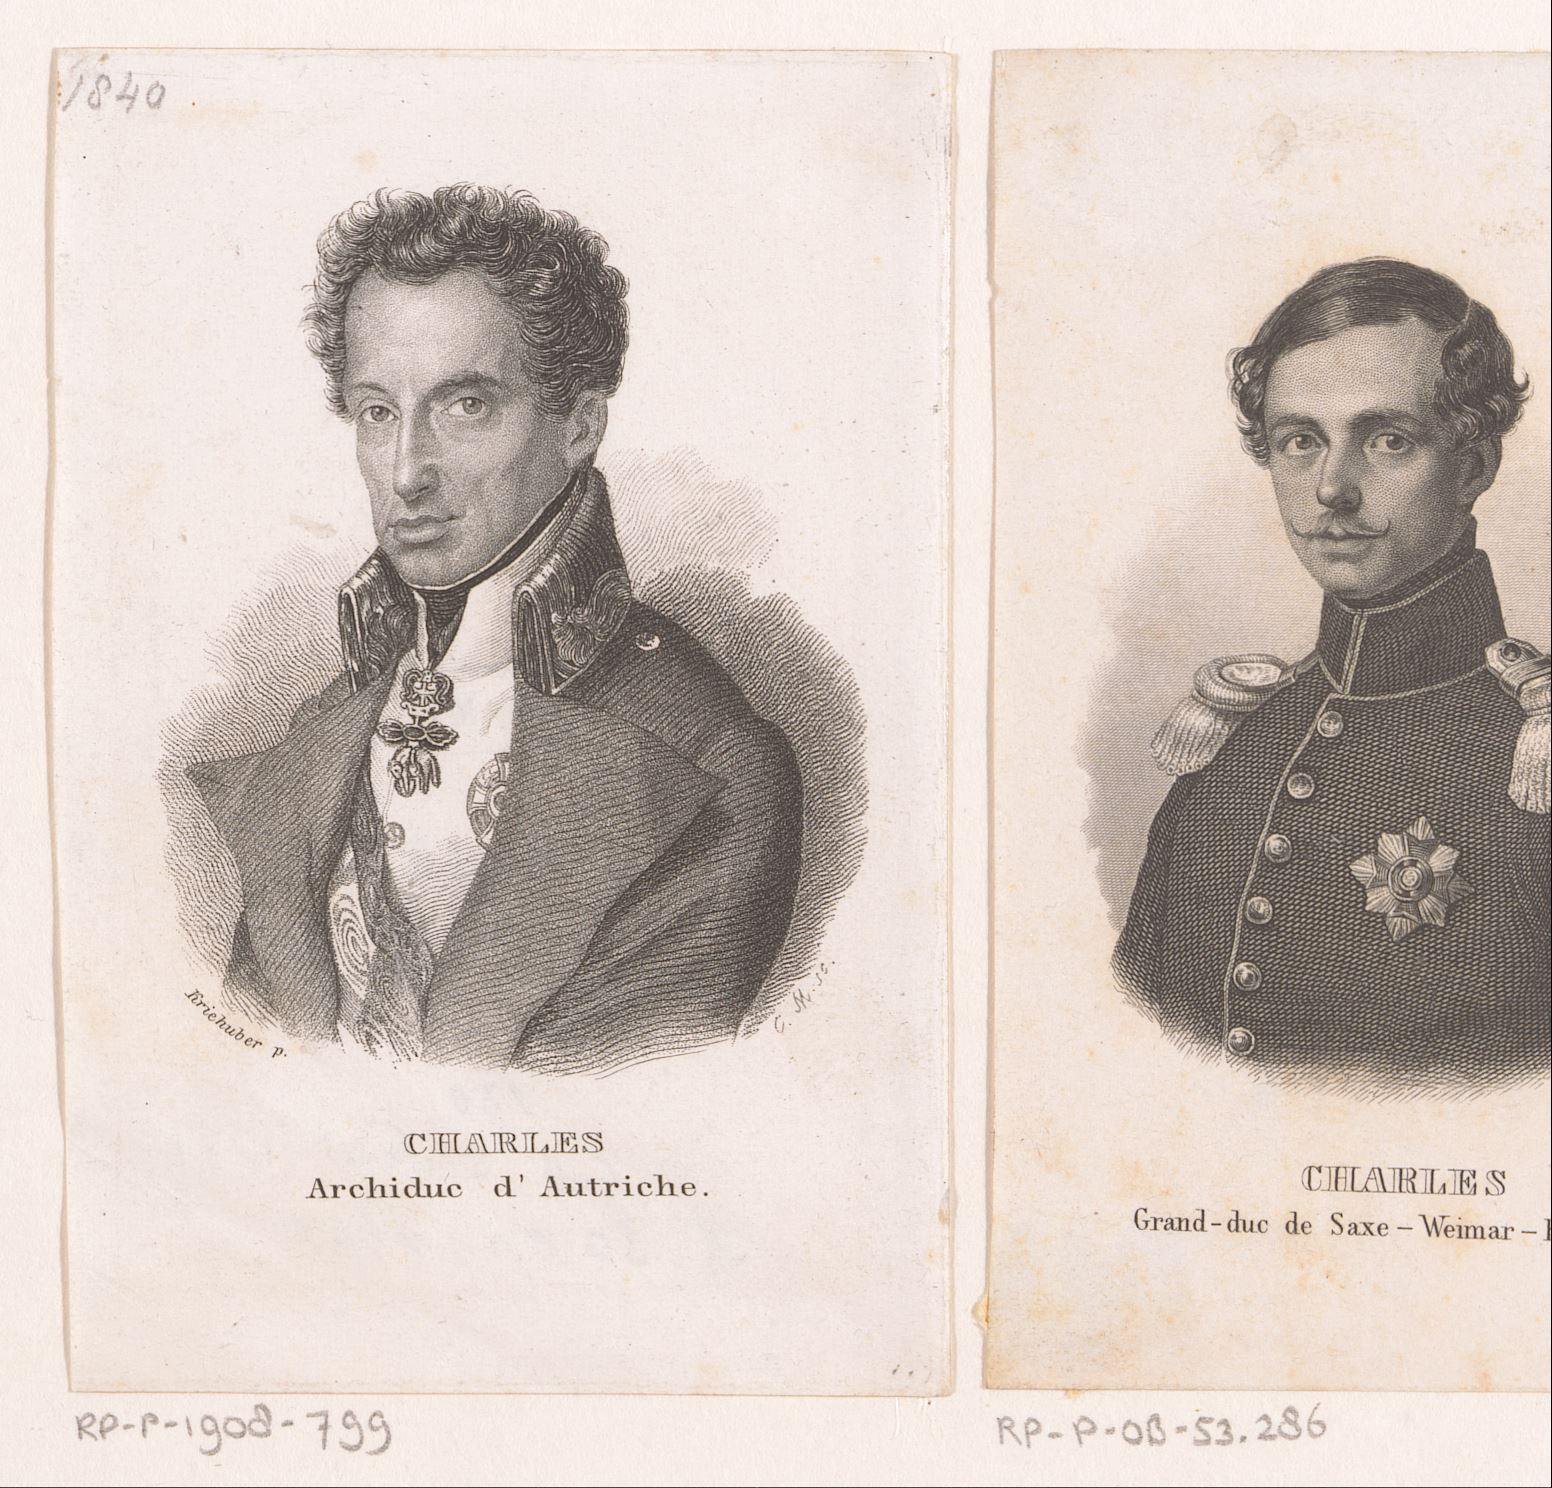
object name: print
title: Portret van Karel Lodewijk Johan, aartshertog van Oostenrijk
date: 1840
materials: paper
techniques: engraving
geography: nuremberg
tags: vienna, historical persons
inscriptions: collector's mark: Lugt 2228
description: Vermoedelijk afkomstig uit: Almanach de Gotha, 1840.